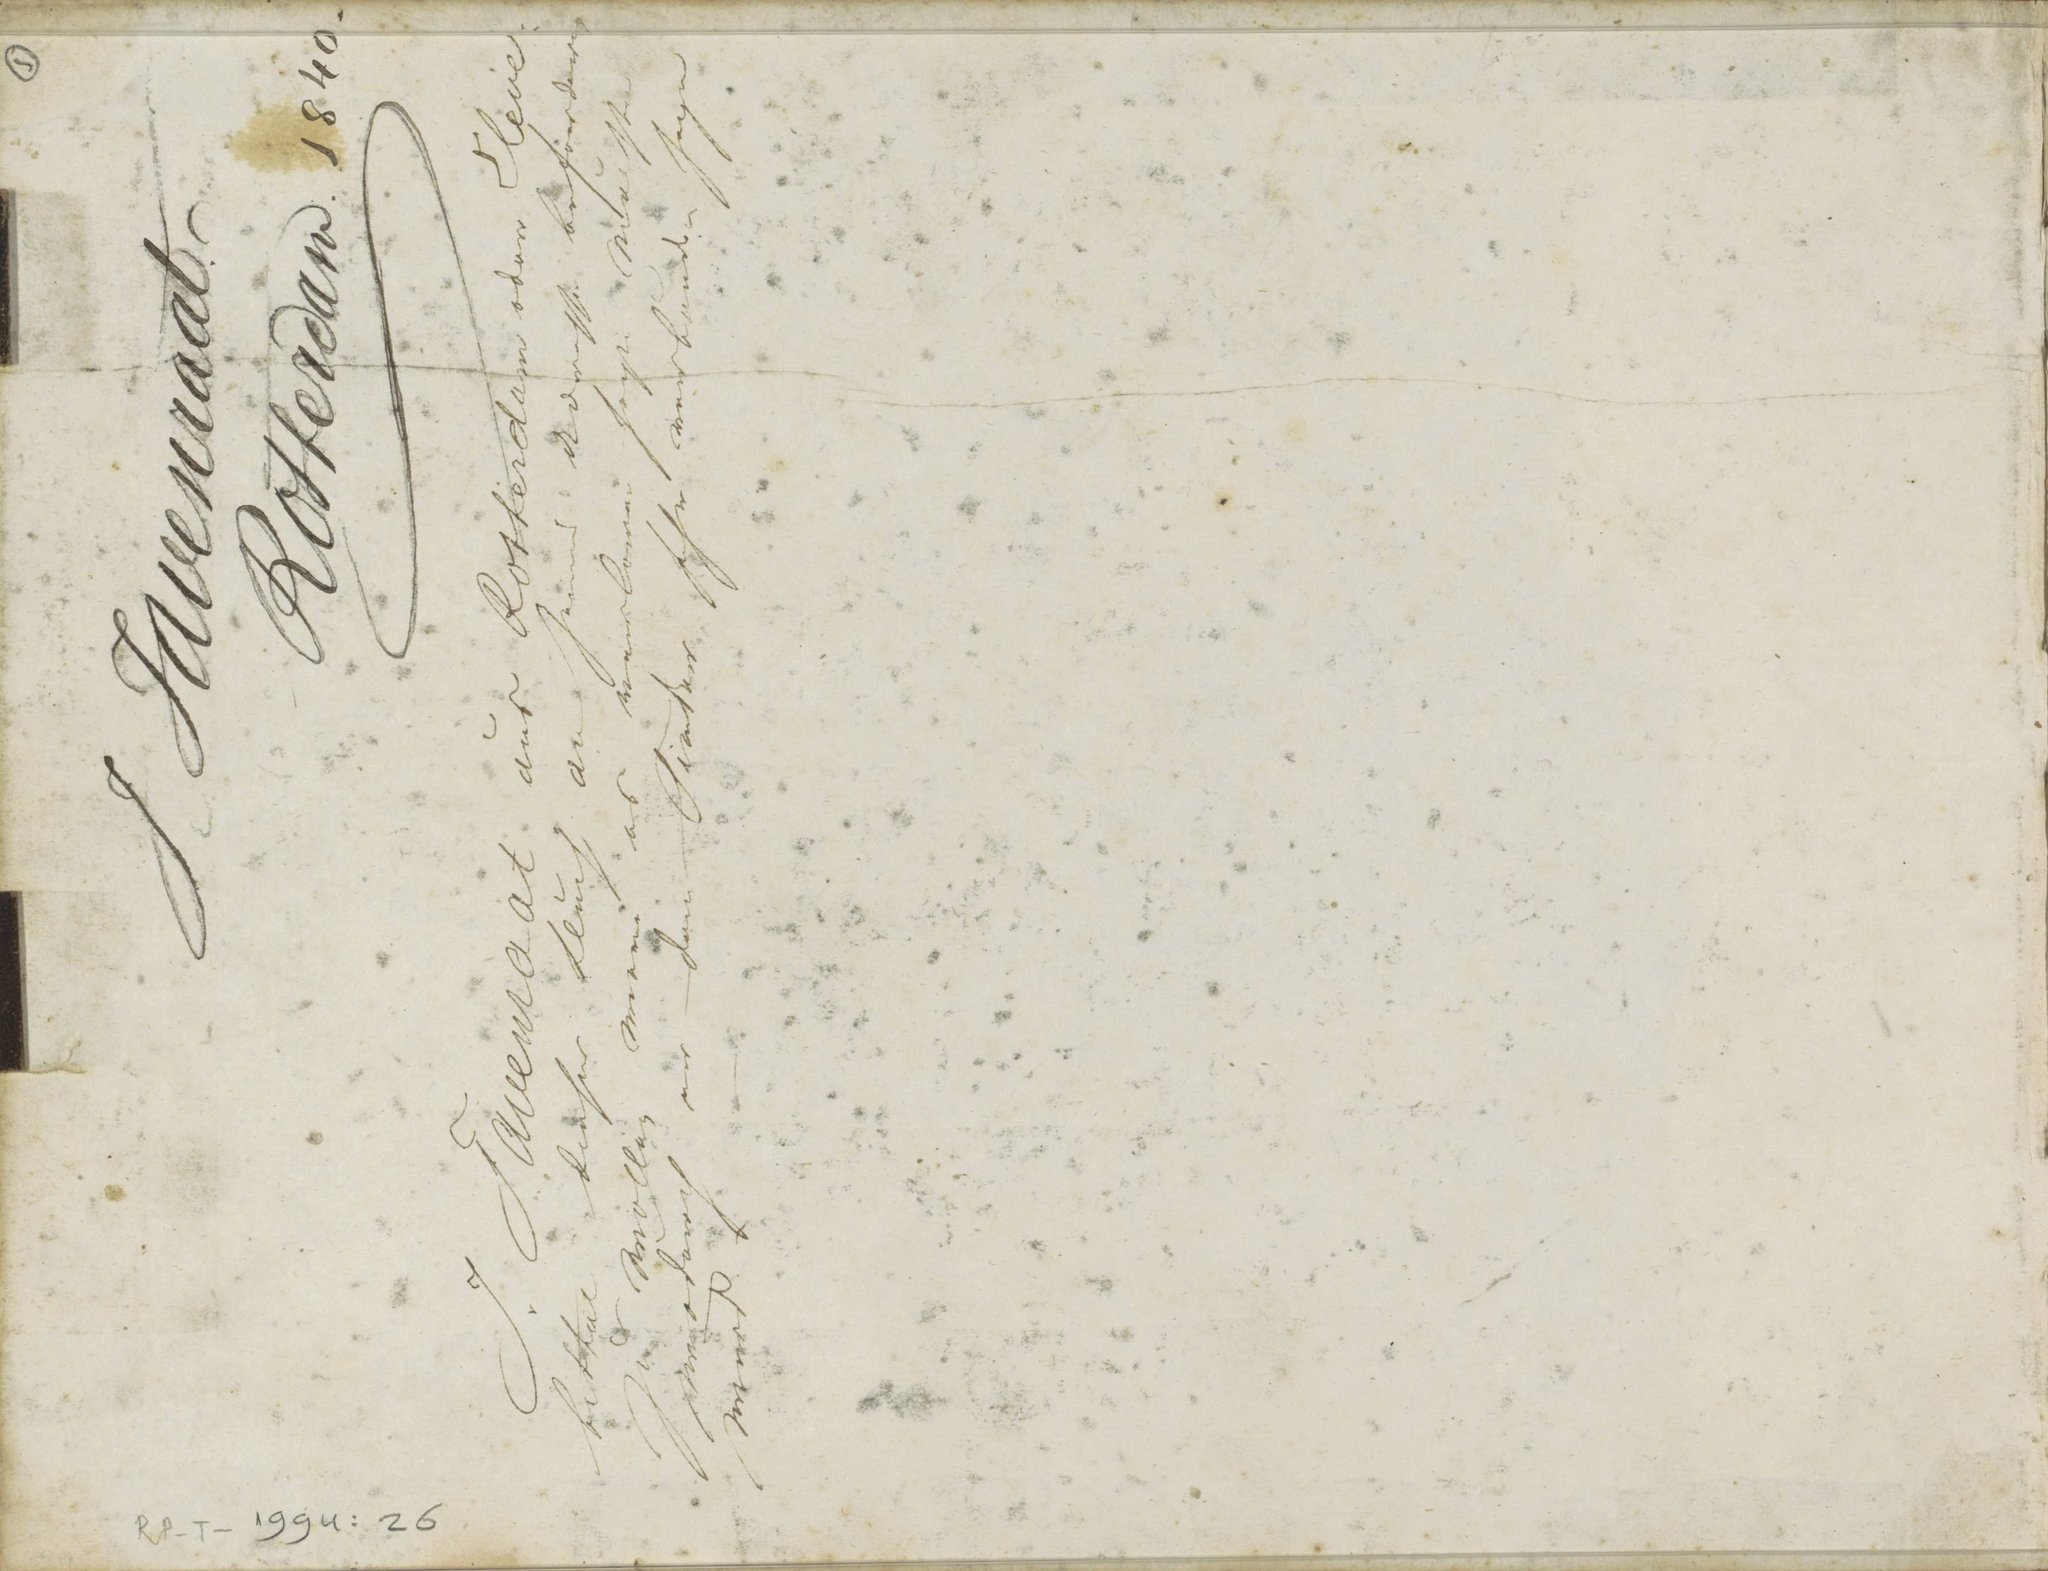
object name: endleaf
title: Signatuur en notities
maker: johannes tavenraat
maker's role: draughtsman, painter, print maker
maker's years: 1809-1881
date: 1840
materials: ink, paper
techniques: pen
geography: rotterdam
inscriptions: signature and date: ‘J. Tavenraat./ Rotterdam. 1840.’, annotation: ‘J. Tavenraat aus Rotterdam [...] Eleve./ bethal [...] au [...]’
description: Voorste schutblad uit een schetsboek met 43 bladen.